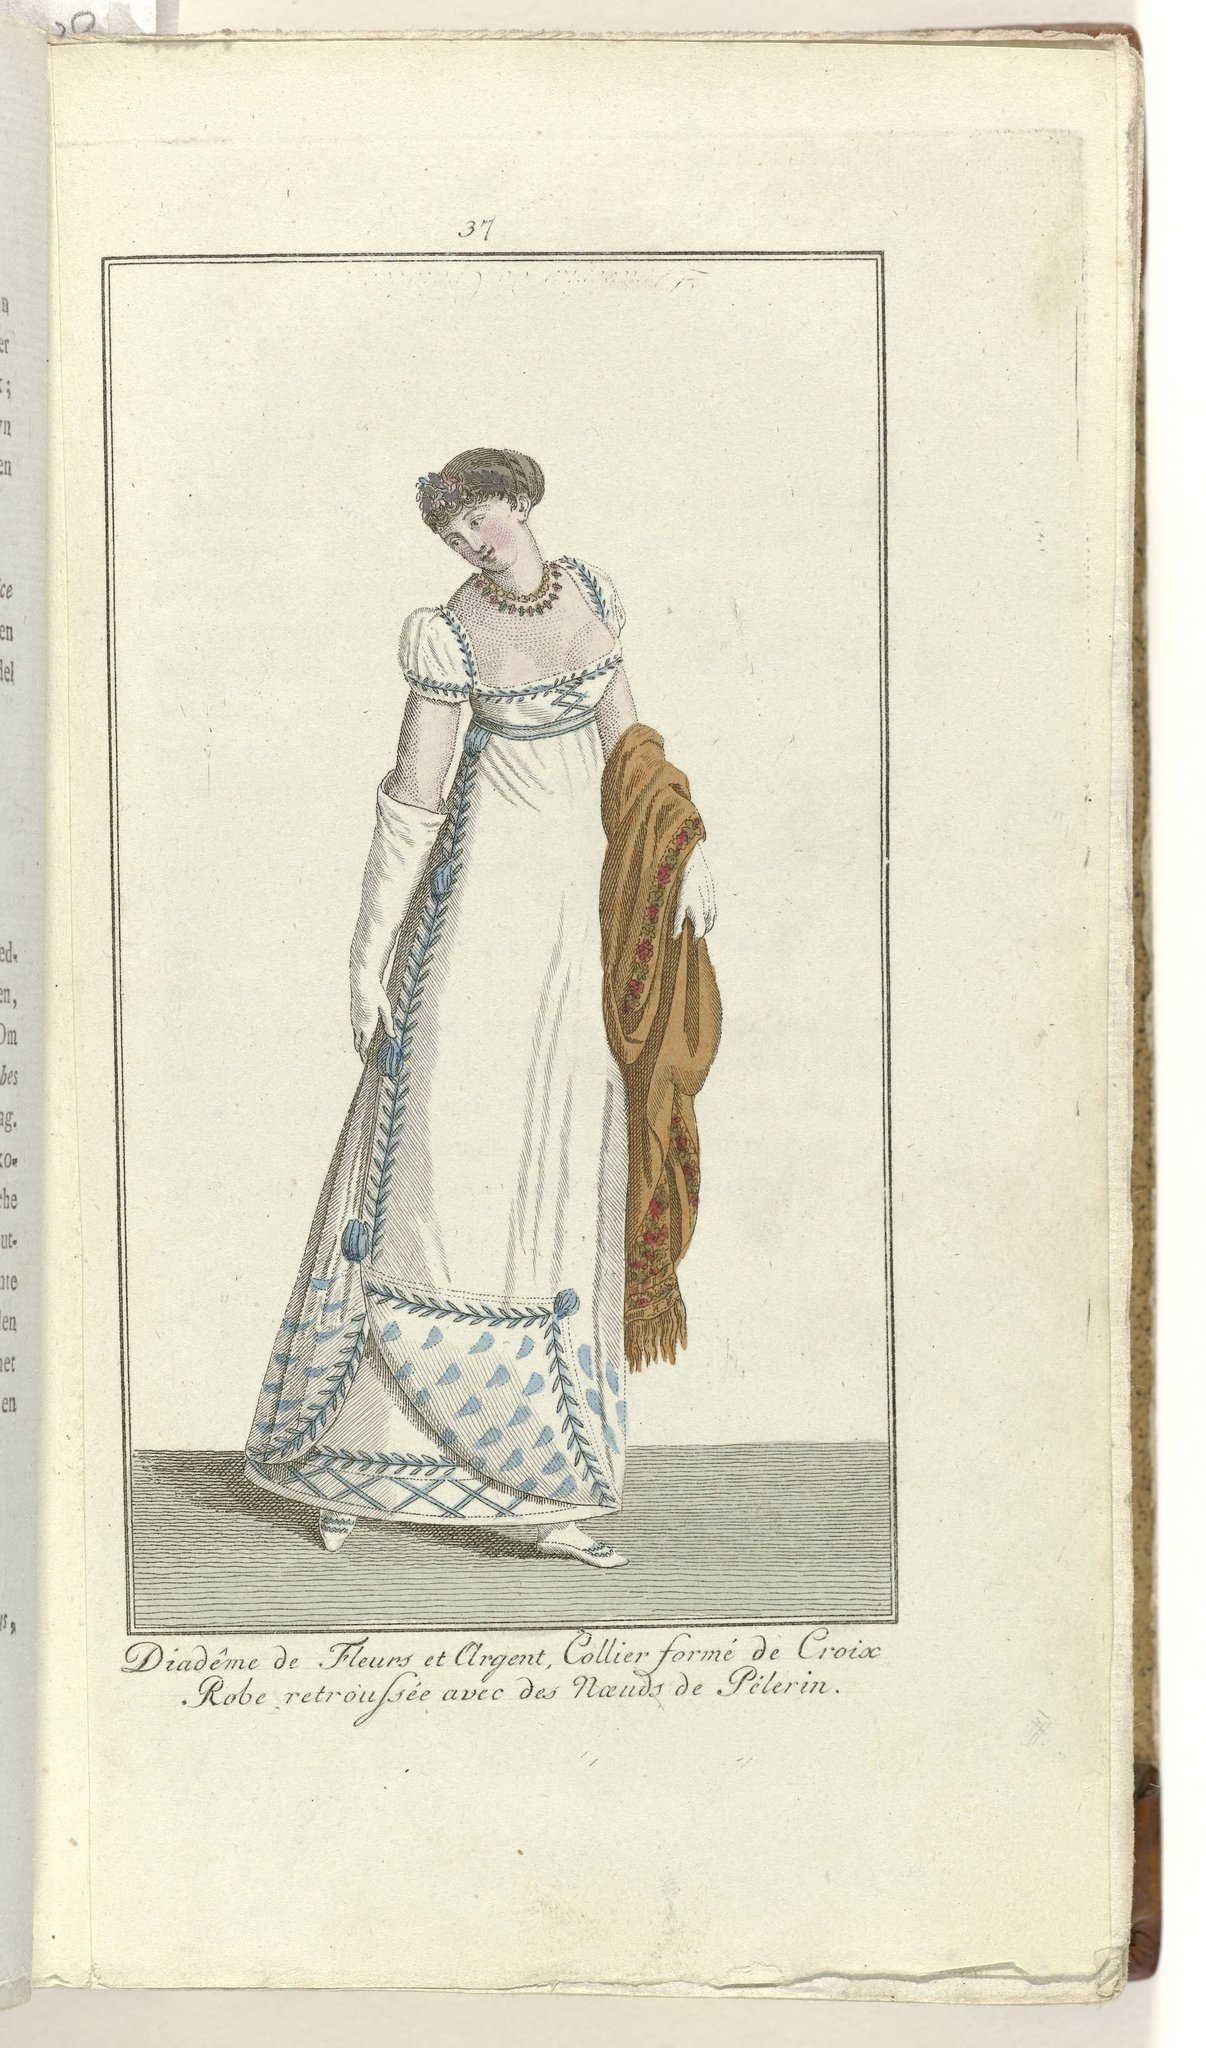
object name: fashion print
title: Elegantia, of tijdschrift van mode, luxe en smaak voor dames, Februari 1808, No. 37: Diadême de Fleurs et Argent,...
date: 1808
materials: paper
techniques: engraving, hand coloring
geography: amsterdam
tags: flowers, diadem, tiara (+ women's clothes), gloves, mittens (long gloves) (+ women's clothes), clothing for the upper part of the body (shawl) (+ women's clothes), fashion plates, dress, gown (+ women's clothes), necklace (+ women's clothes)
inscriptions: caption: ‘Diadême de Fleurs et Argent, Collier formé de Croix Robe retroussée avec des Noeuds de Pélerin.’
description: Volgens de begeleidende tekst (p. 64): Een deels opgetrokken japon, met gebladerte (?) gegarneerd. Diadeem van bloemen en zilver. Collier in de vorm van kruizen(?). Turks gele 'Cachemire' (sjaal). Volgens het onderschrift wordt de japon opgehouden door 'noeuds de Pélerin'. (knopen of strikken?). Prent uit het modetijdschrift Elegantia, of tijdschrift van mode, luxe en smaak voor dames 1807-1814 (onderbroken door de periode 1811-1813).